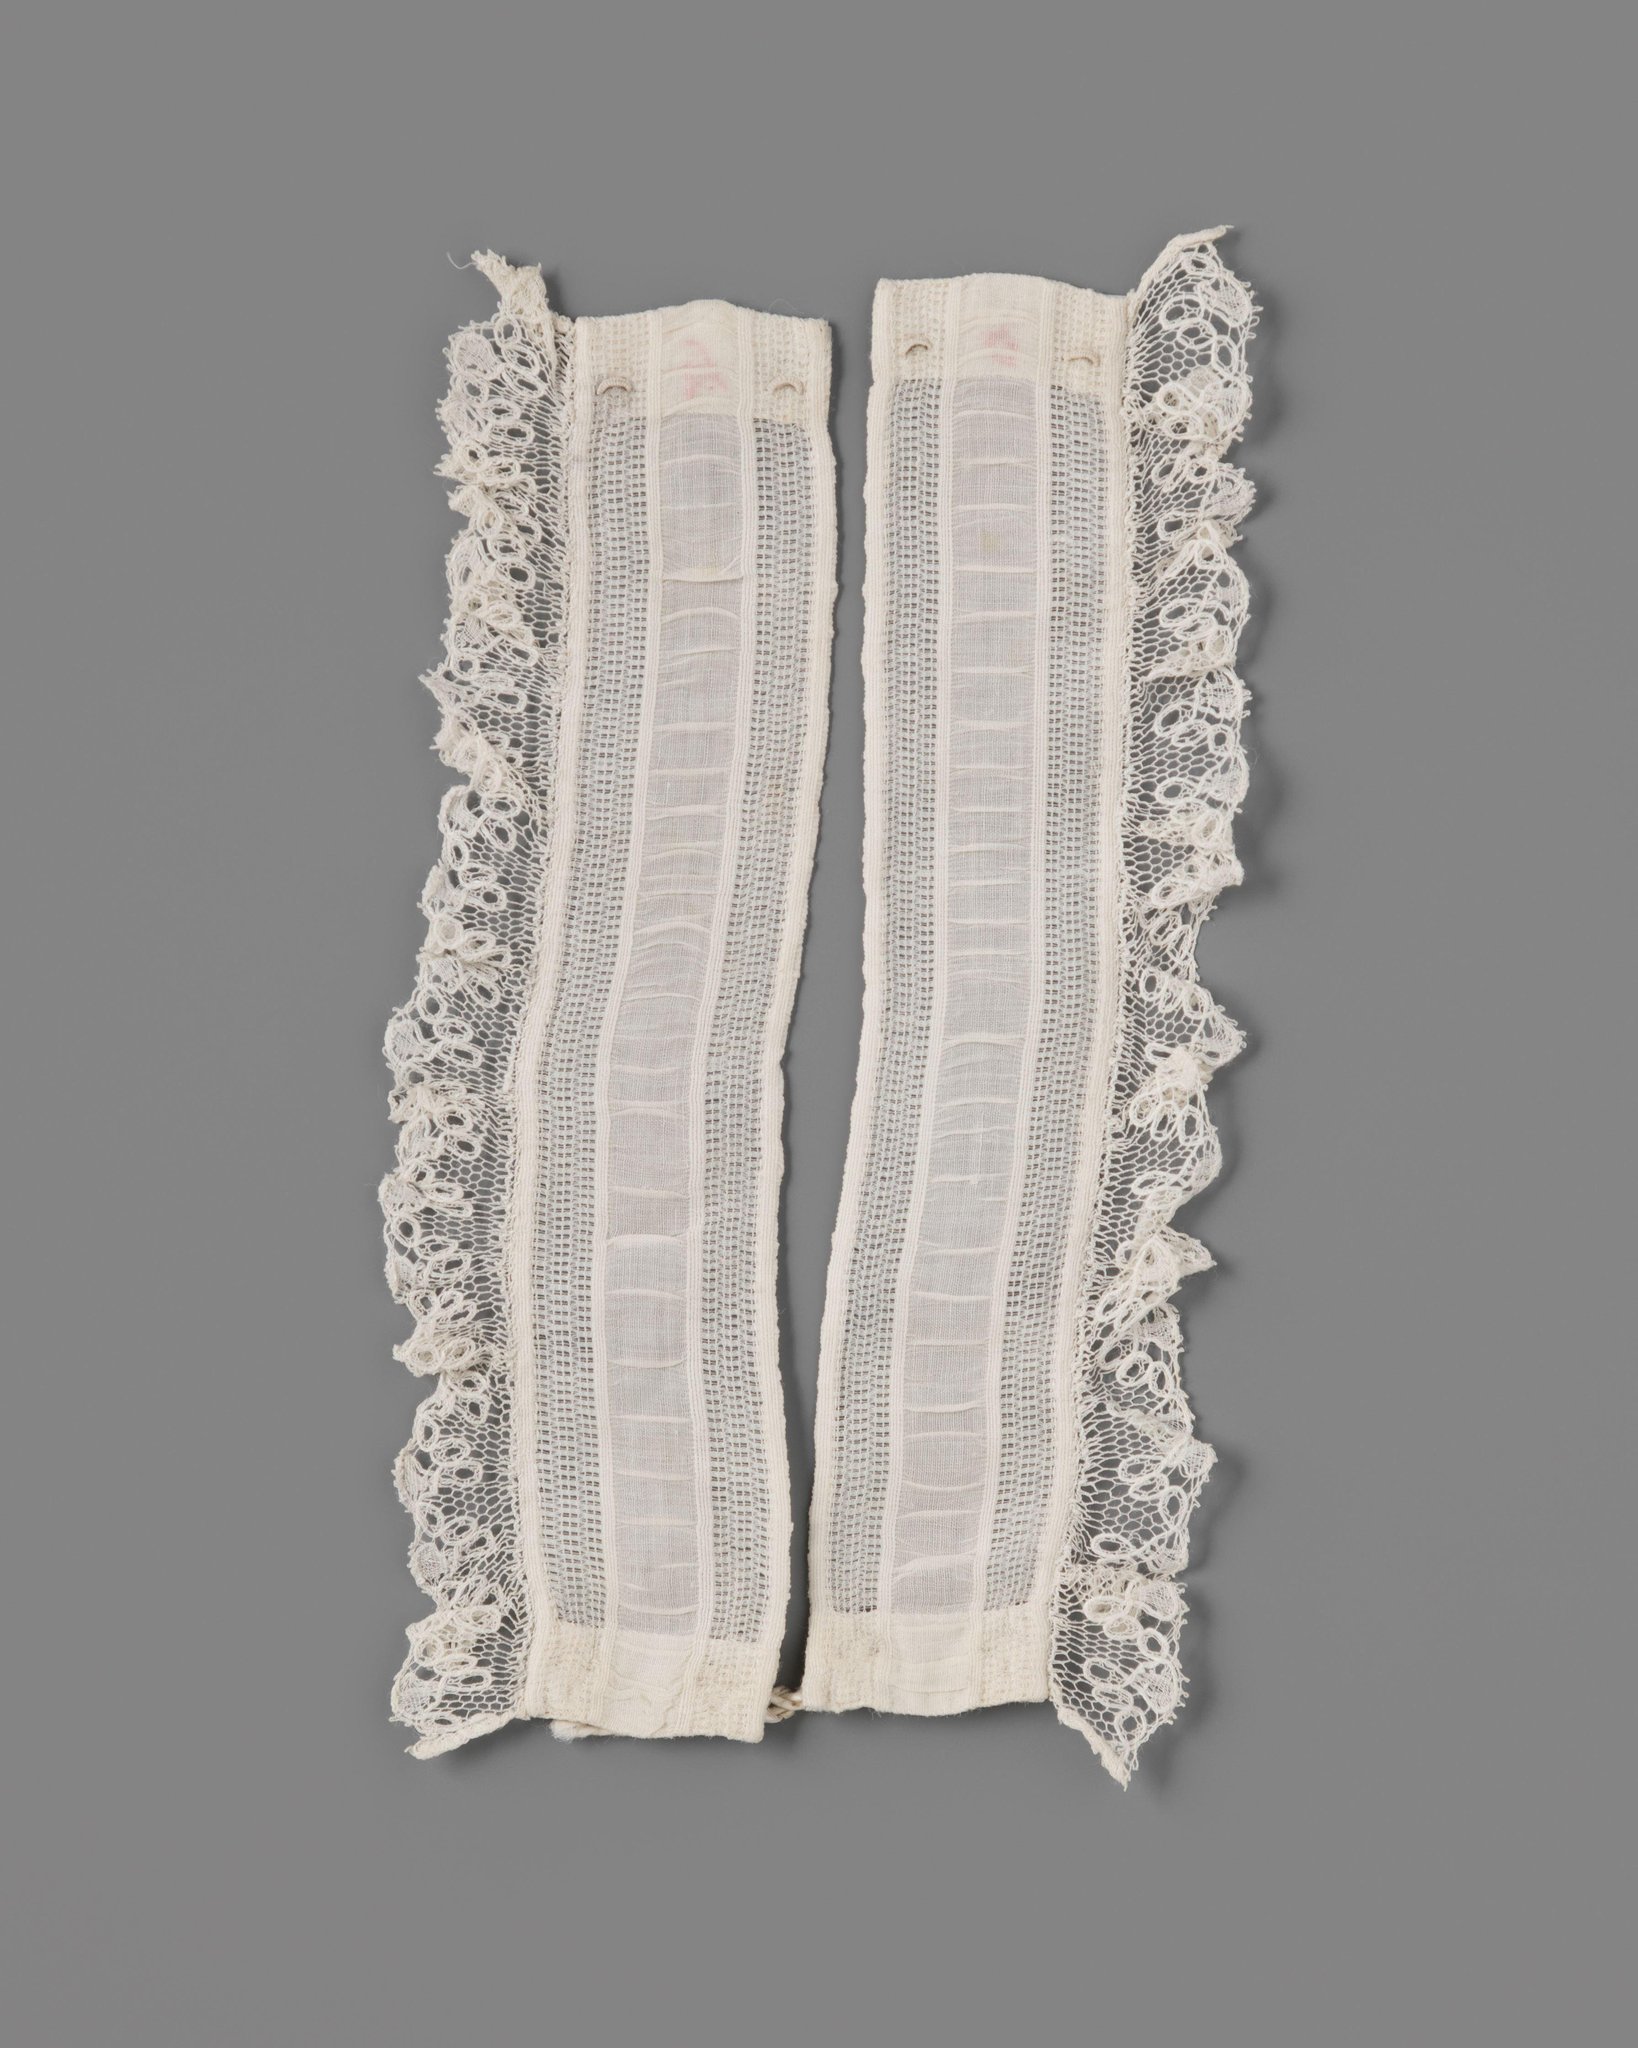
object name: cuff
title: Manchet van stof afgezet met een gerimpelde strook Rijsselse kant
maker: Anonymous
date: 1880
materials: lace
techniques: cockled, cross stitching, lace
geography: western europe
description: Manchet bestaande uit een rechte strook stof die is afgezet met een gerimpelde strook Rijsselse kant. Het kant heeft een lussenpatroon bij de schulpen. De manchet kan worden gesloten door middel van twee haken en ogen. Gemerkt met een in kruissteek geborduurde A.